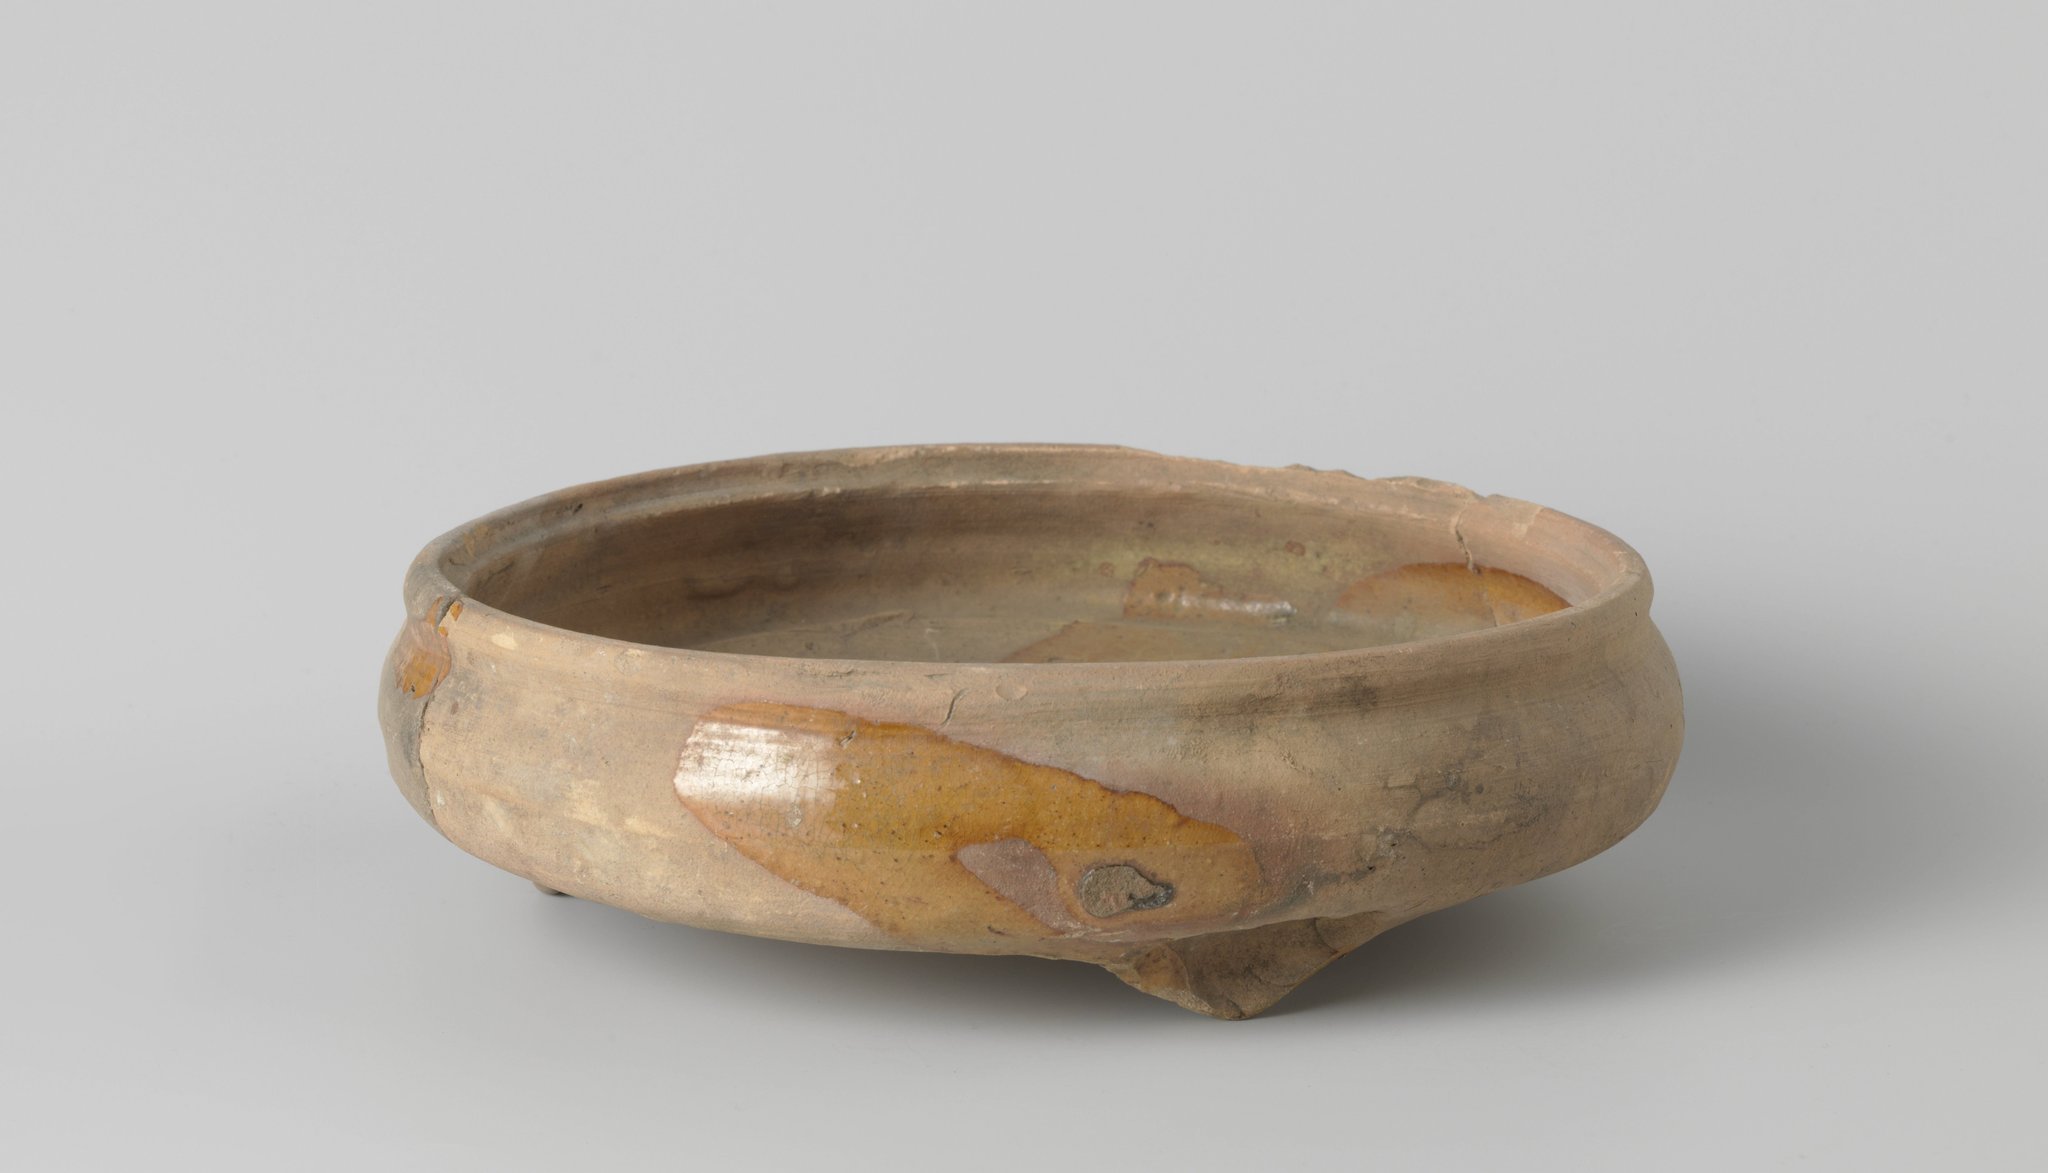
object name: container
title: Bak van rood-bruin aardewerk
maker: Anonymous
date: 1500-1700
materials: earthenware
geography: netherlands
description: Bak van rood-bruin aardewerk. De bak staat op drie met de hand en spatel gevormde voeten. Op de buitenzijde van de bolle wand en aan de binnenzijde van de schotel bevinden zich enkele geel-bruine glazuurplekken. De bak is in tweeën gebroken en gelijmd.